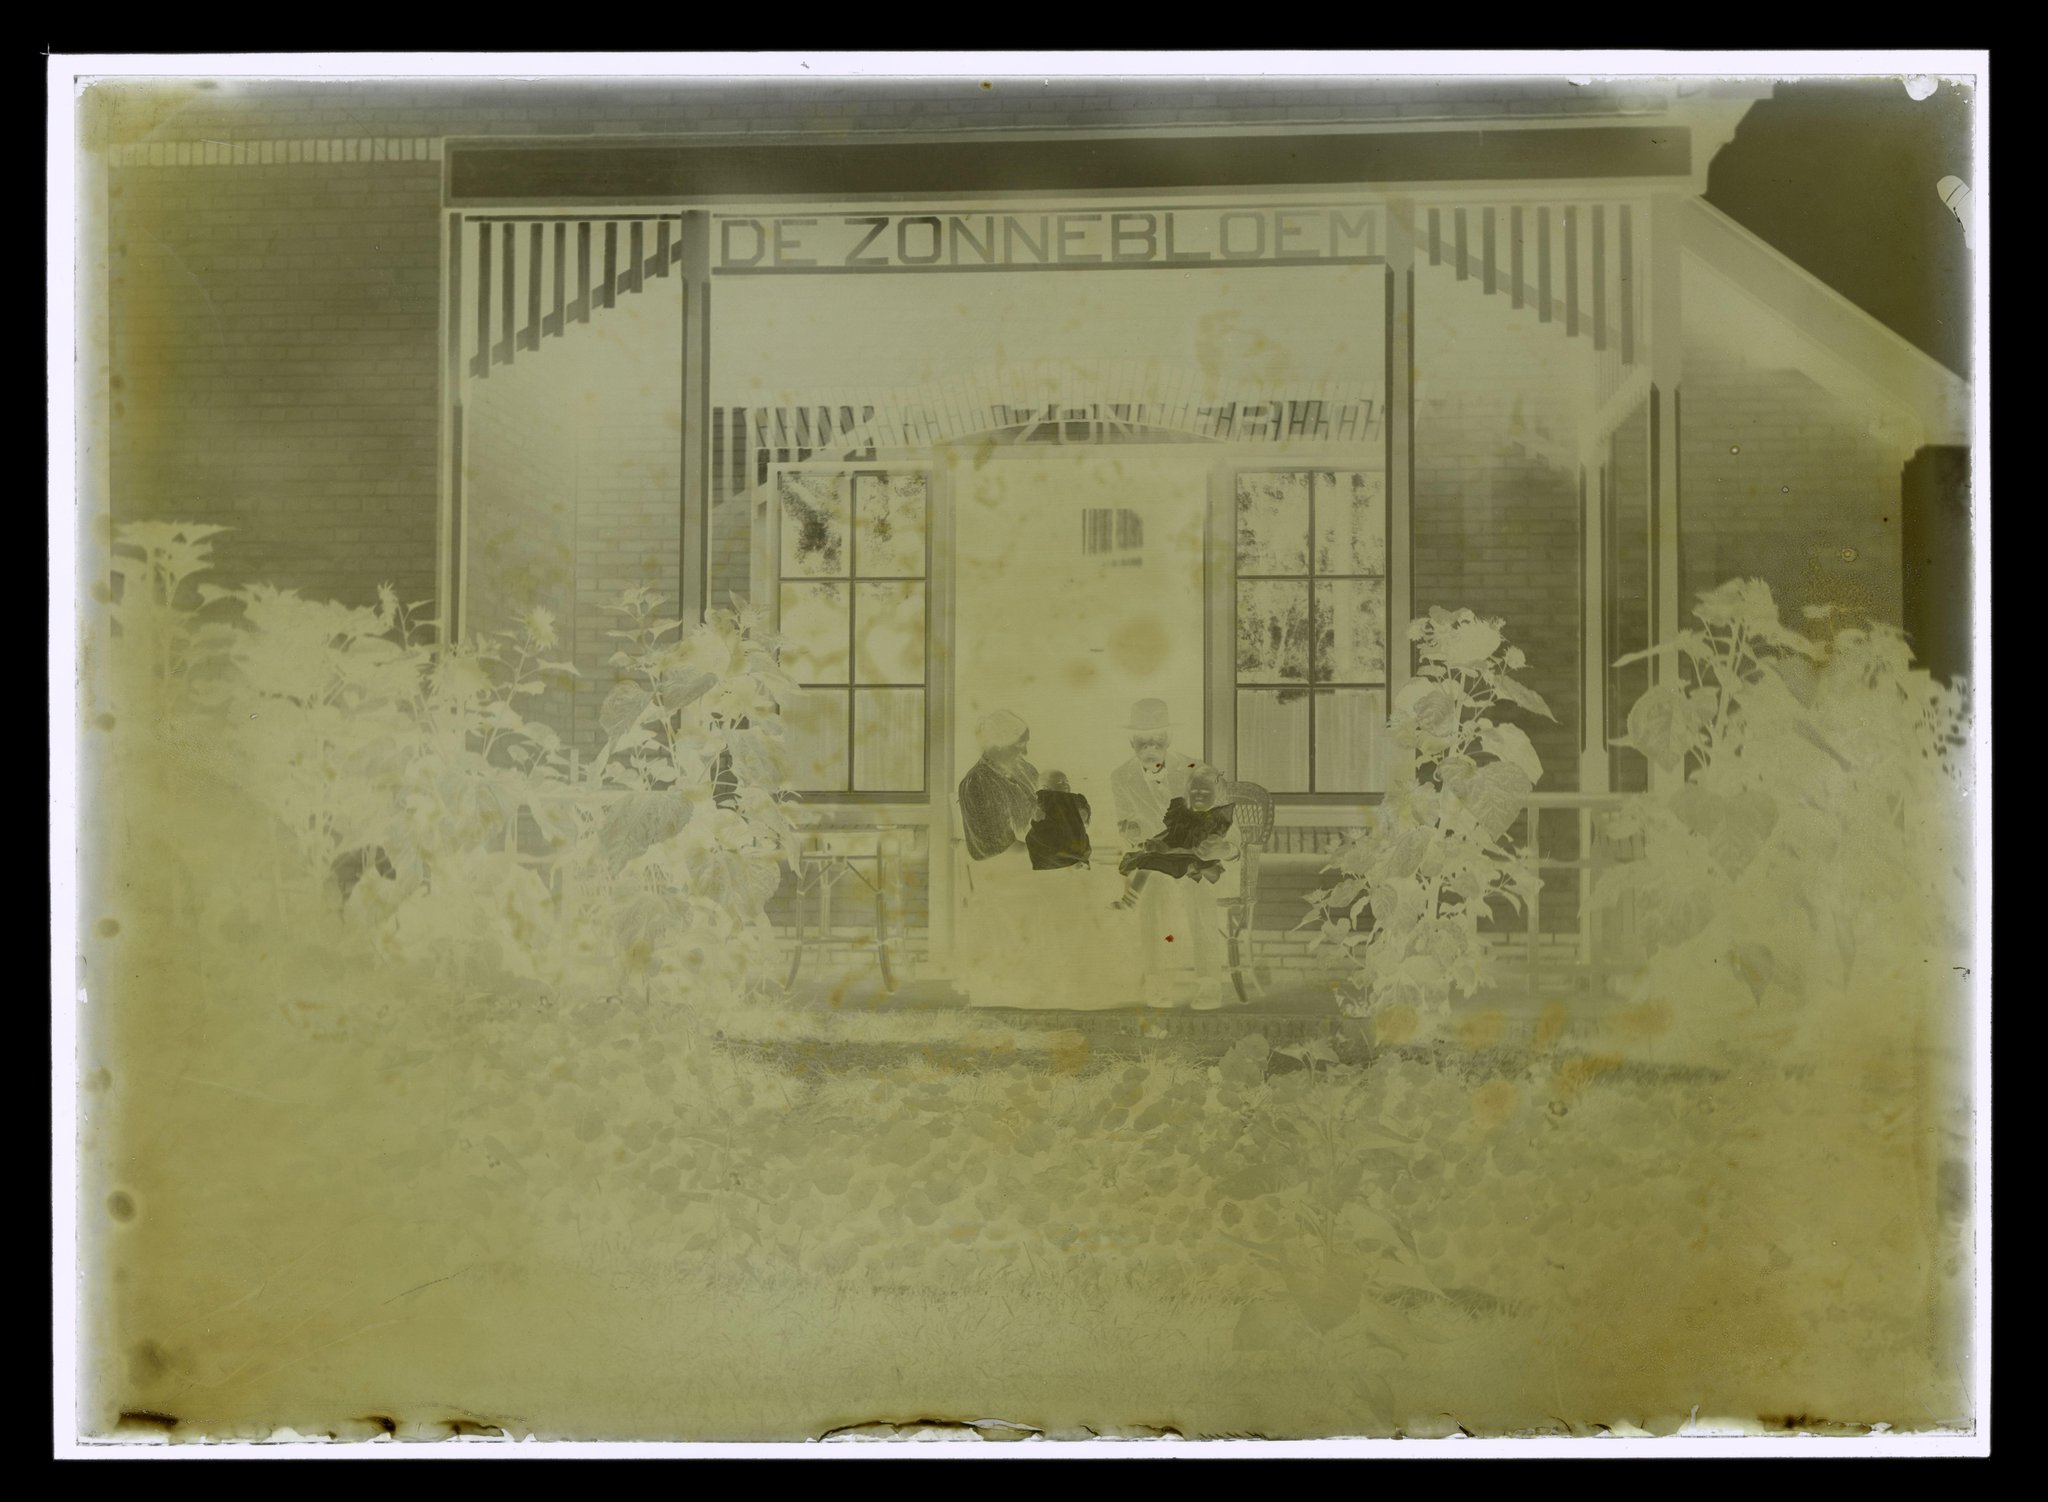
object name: glasnegatief, glasplaatnegatief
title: Alphons en Elsa Diepenbrock met dochters Thea en Joanna op een veranda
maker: wouterus gijsbertus hondius van den broek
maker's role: amateurfotograaf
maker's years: 1867-1913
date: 1907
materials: glass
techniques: gelatin glass negative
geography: netherlands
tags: elsa diepenbrock, amsterdam, alphons diepenbrock, family group, especially parents with their child(ren), loggia, verandah, porch